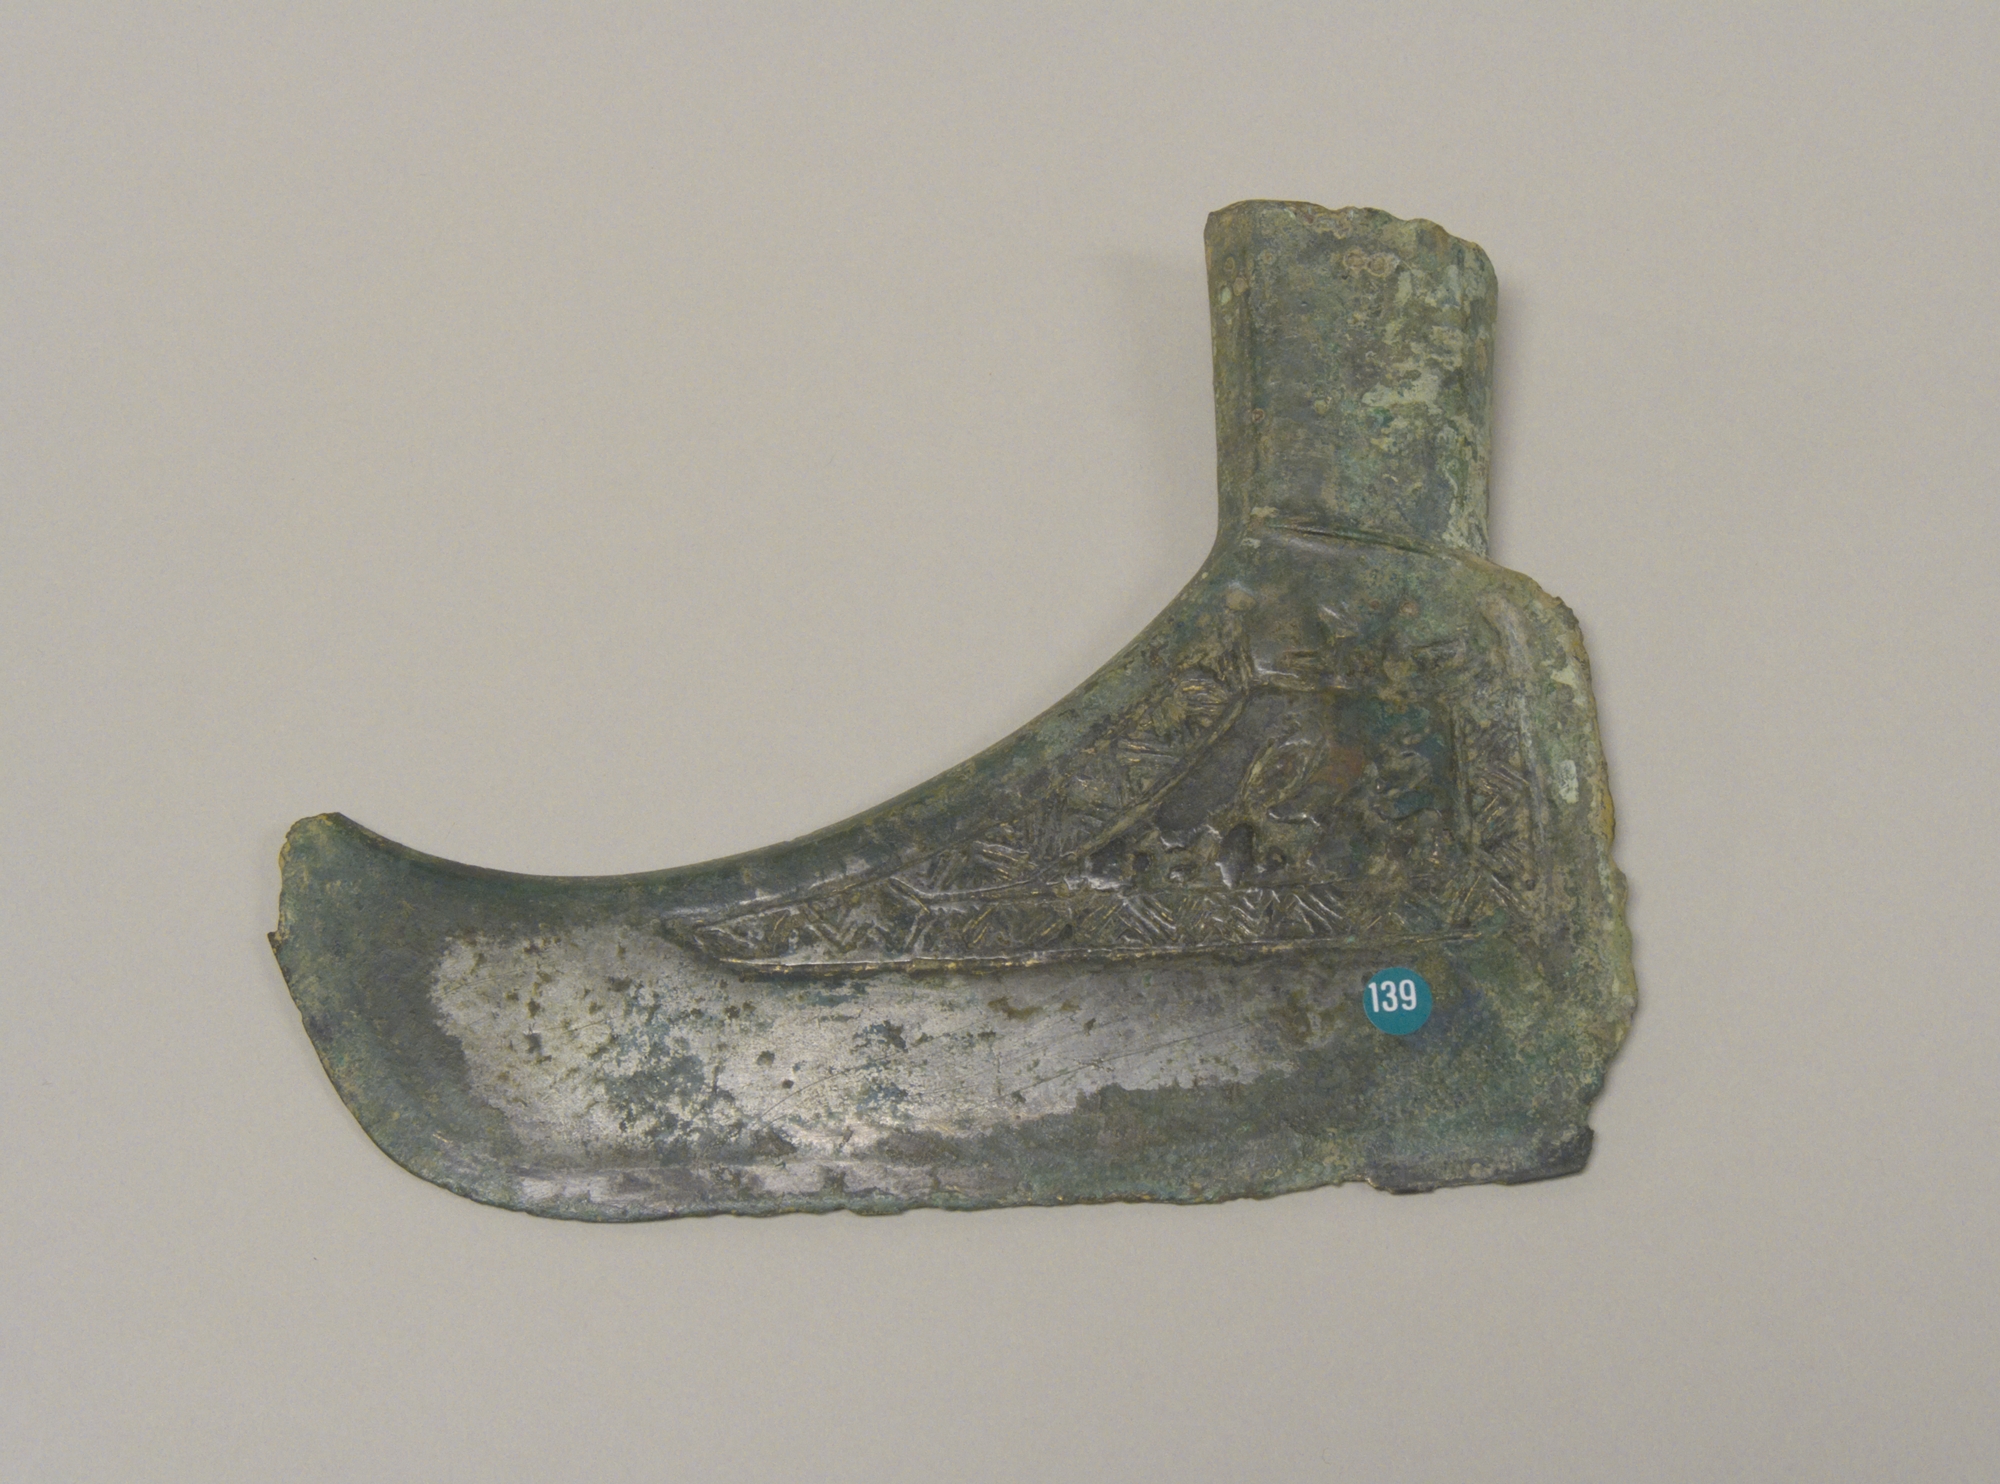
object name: hafted ax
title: Boat-Shaped Hafted Ax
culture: vietnamese, dong son culture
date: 500 BCE-300 CE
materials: bronze